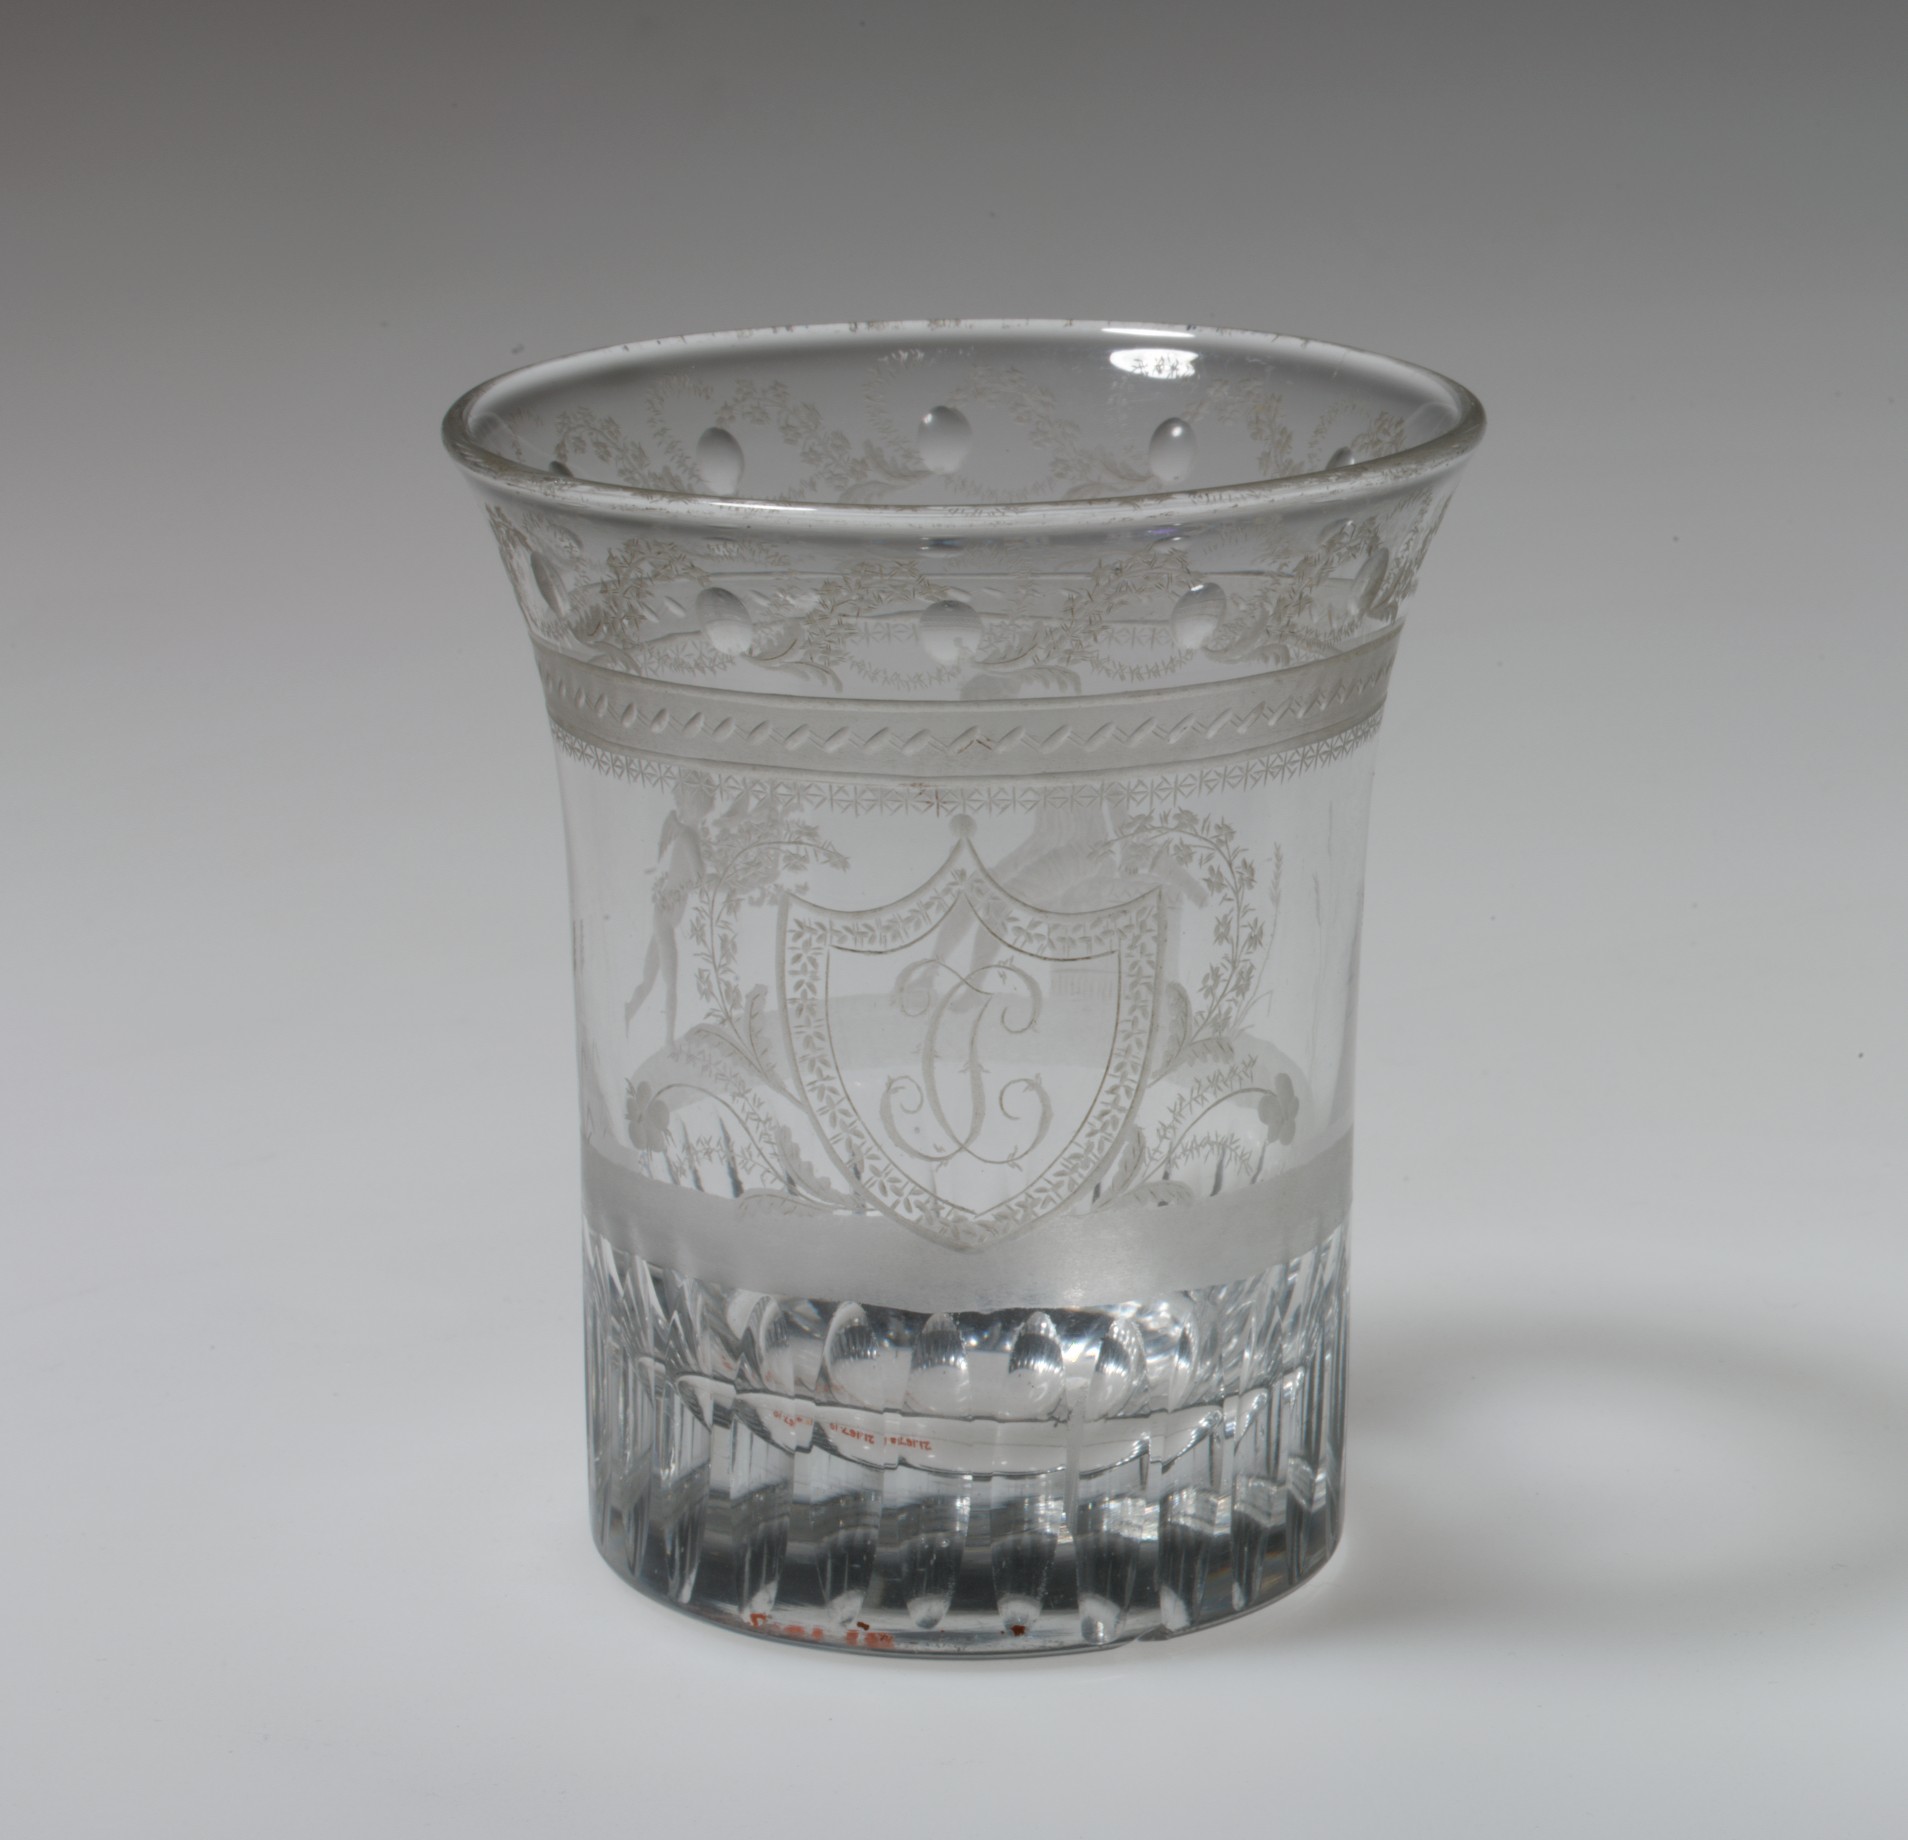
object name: tumbler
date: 1790-1810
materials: glass